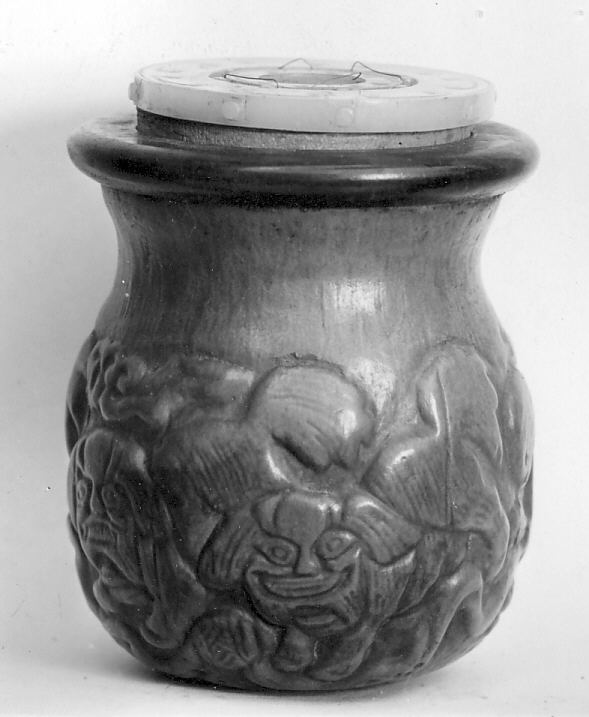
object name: cricket cage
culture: chinese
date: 1701-1900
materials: jade, wood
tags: dogs